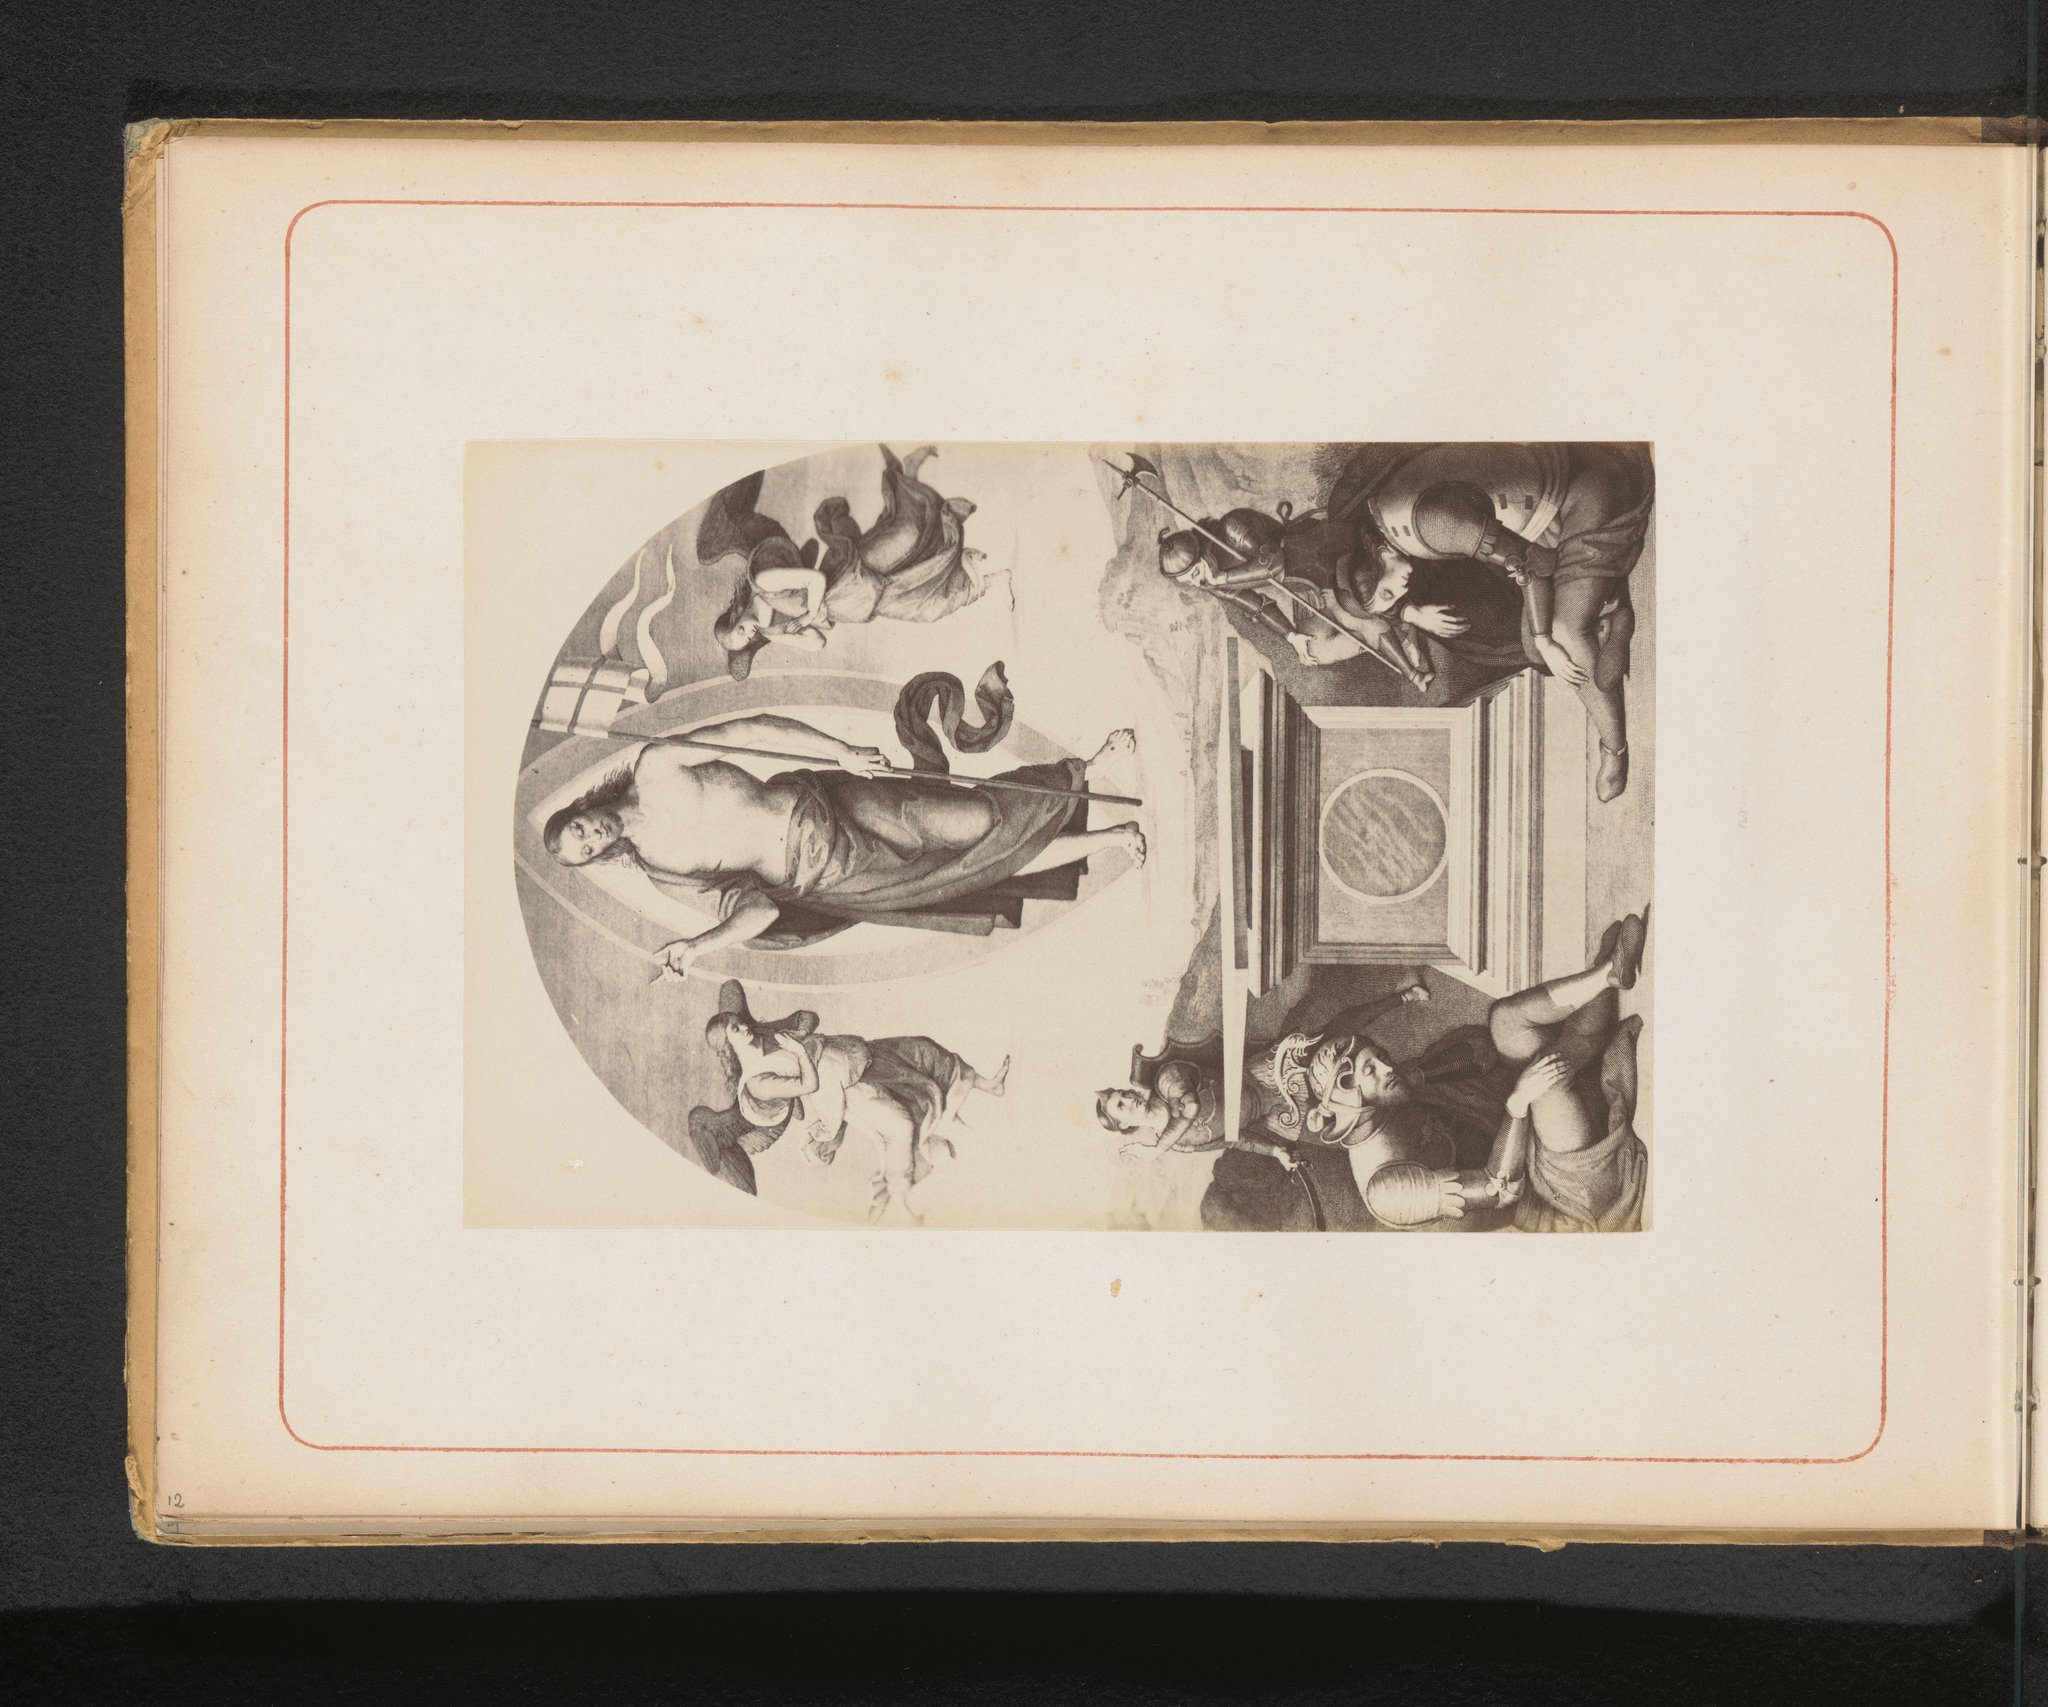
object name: photograph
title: Fotoreproductie van een gravure naar De wederopstanding door Pietro Perugino in het Vaticaan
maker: Anonymous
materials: photographic support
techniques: albumen print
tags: christ, usually holding a banner, arises from the grave; often combined with sleeping and/or frightened soldiers